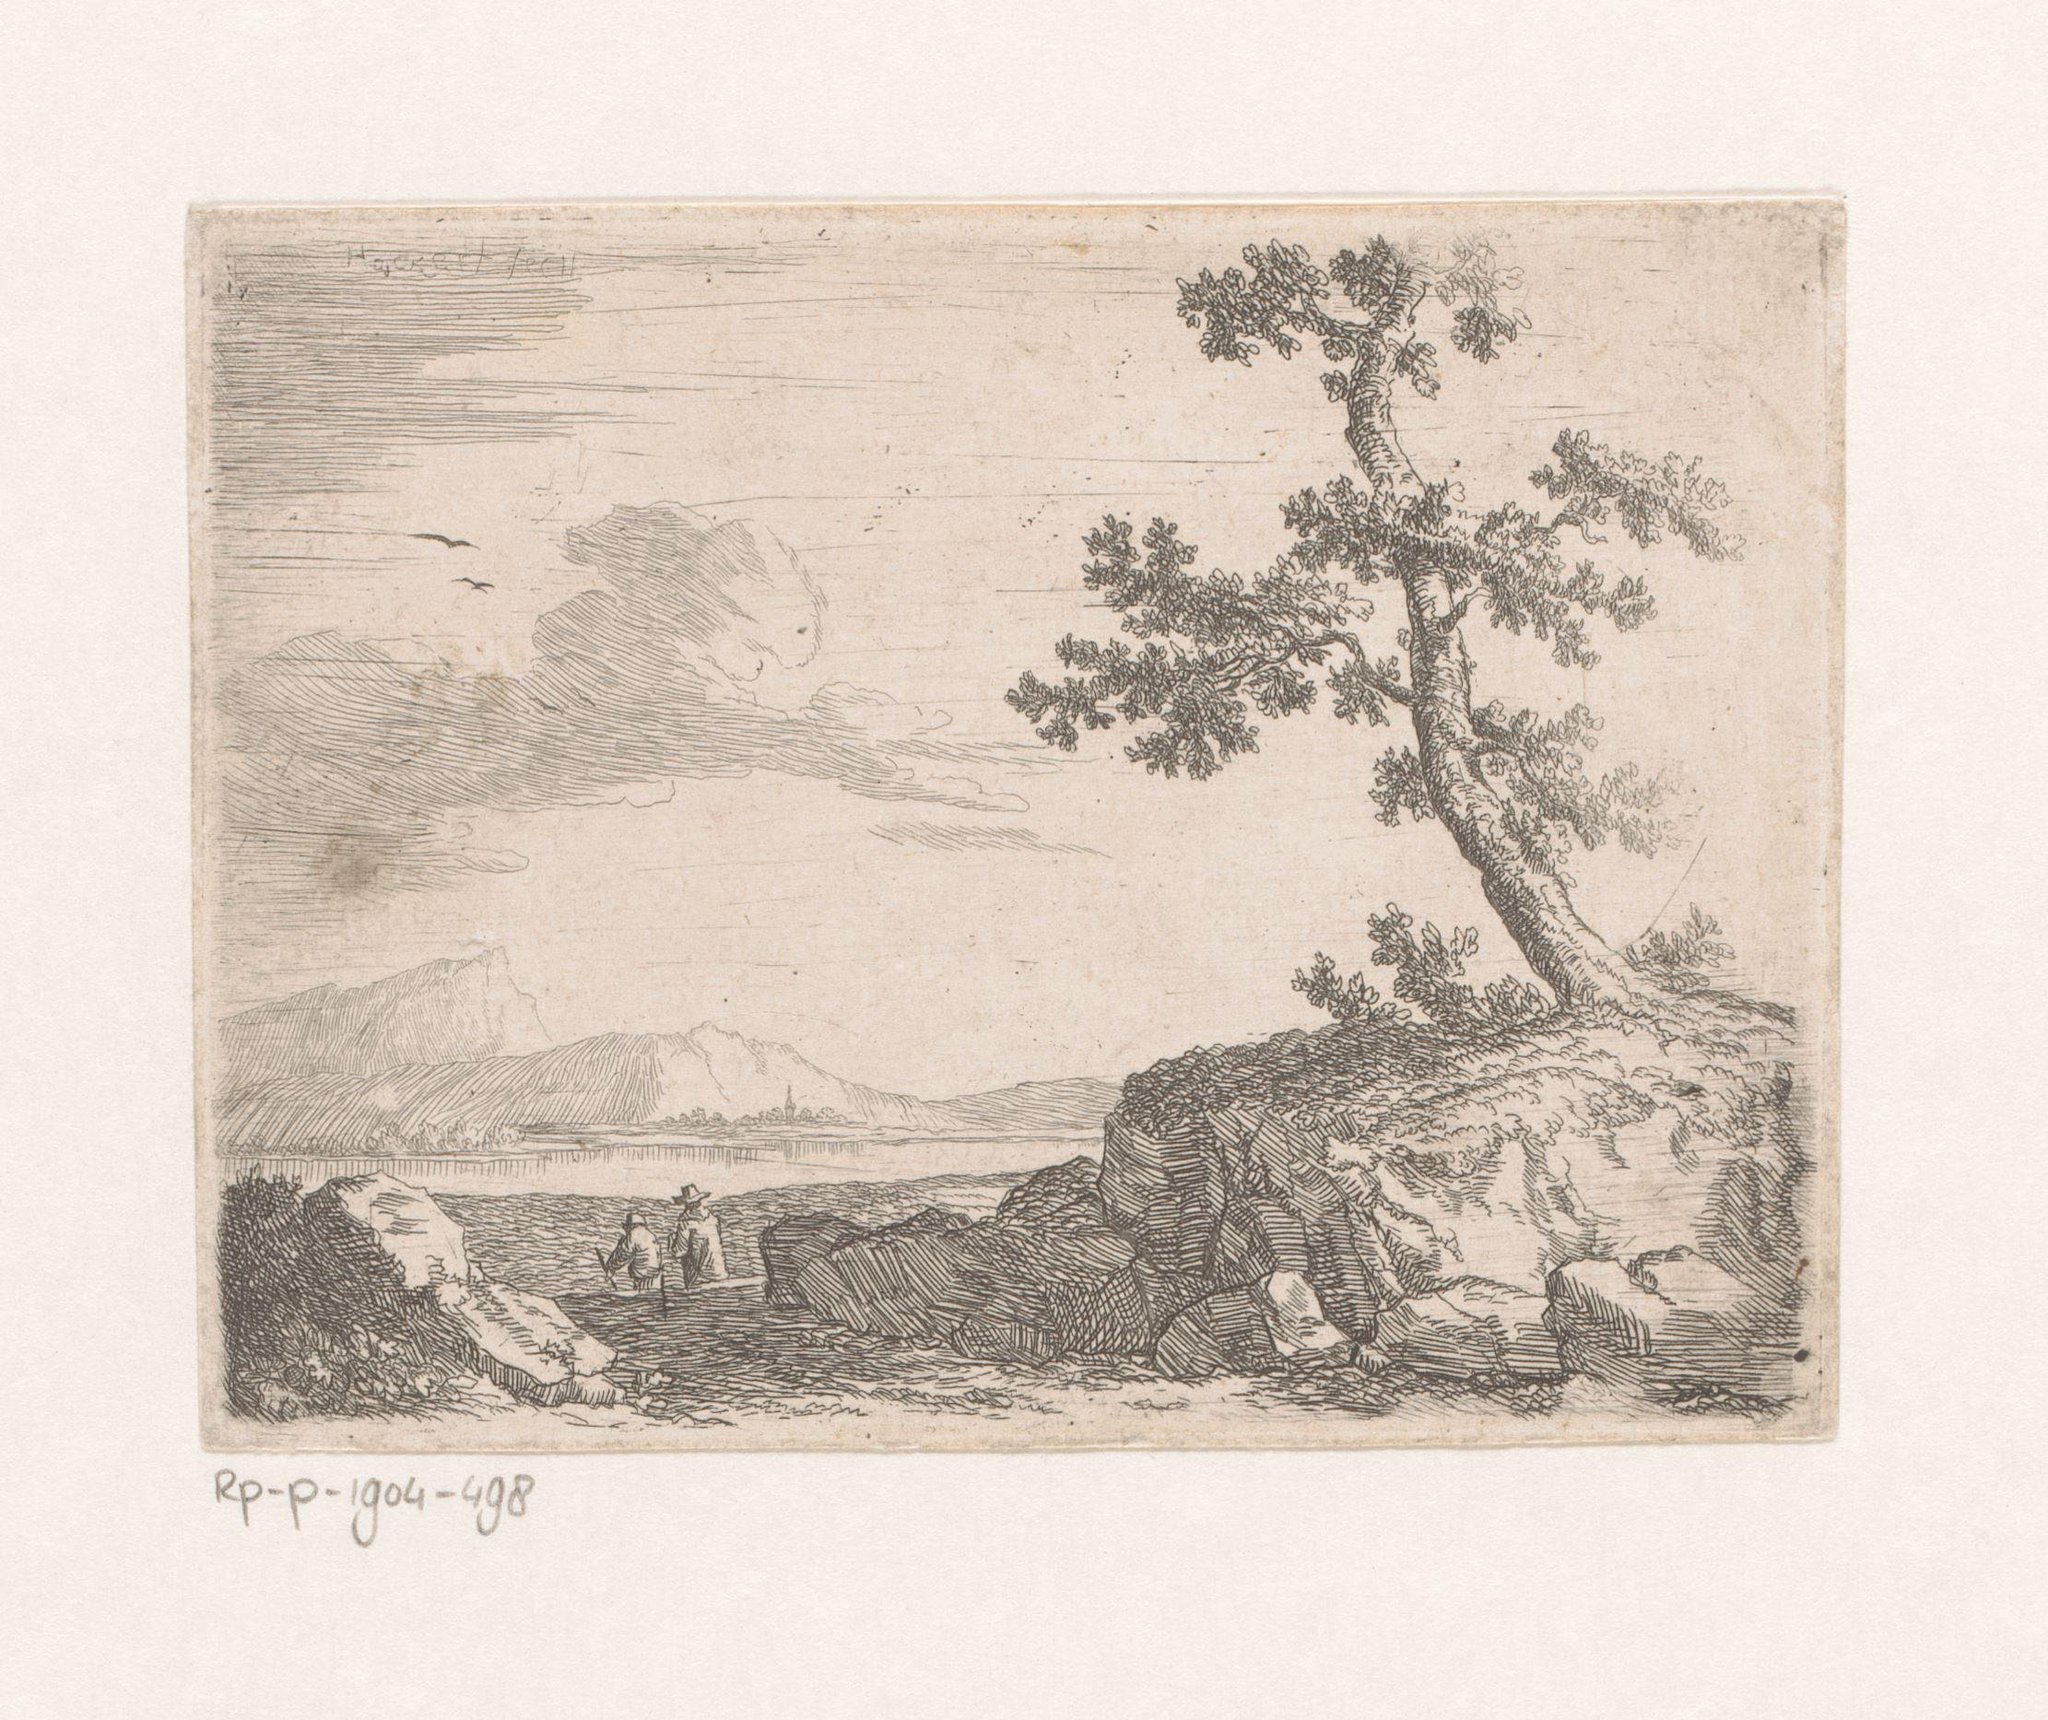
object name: print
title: Kustlandschap met boom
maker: jacob philipp hackert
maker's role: painter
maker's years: 1737-1807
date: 1747-1807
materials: paper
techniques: etching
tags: fabulous trees, coast (+ landscape with figures, staffage)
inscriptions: collector's mark: Lugt 2228